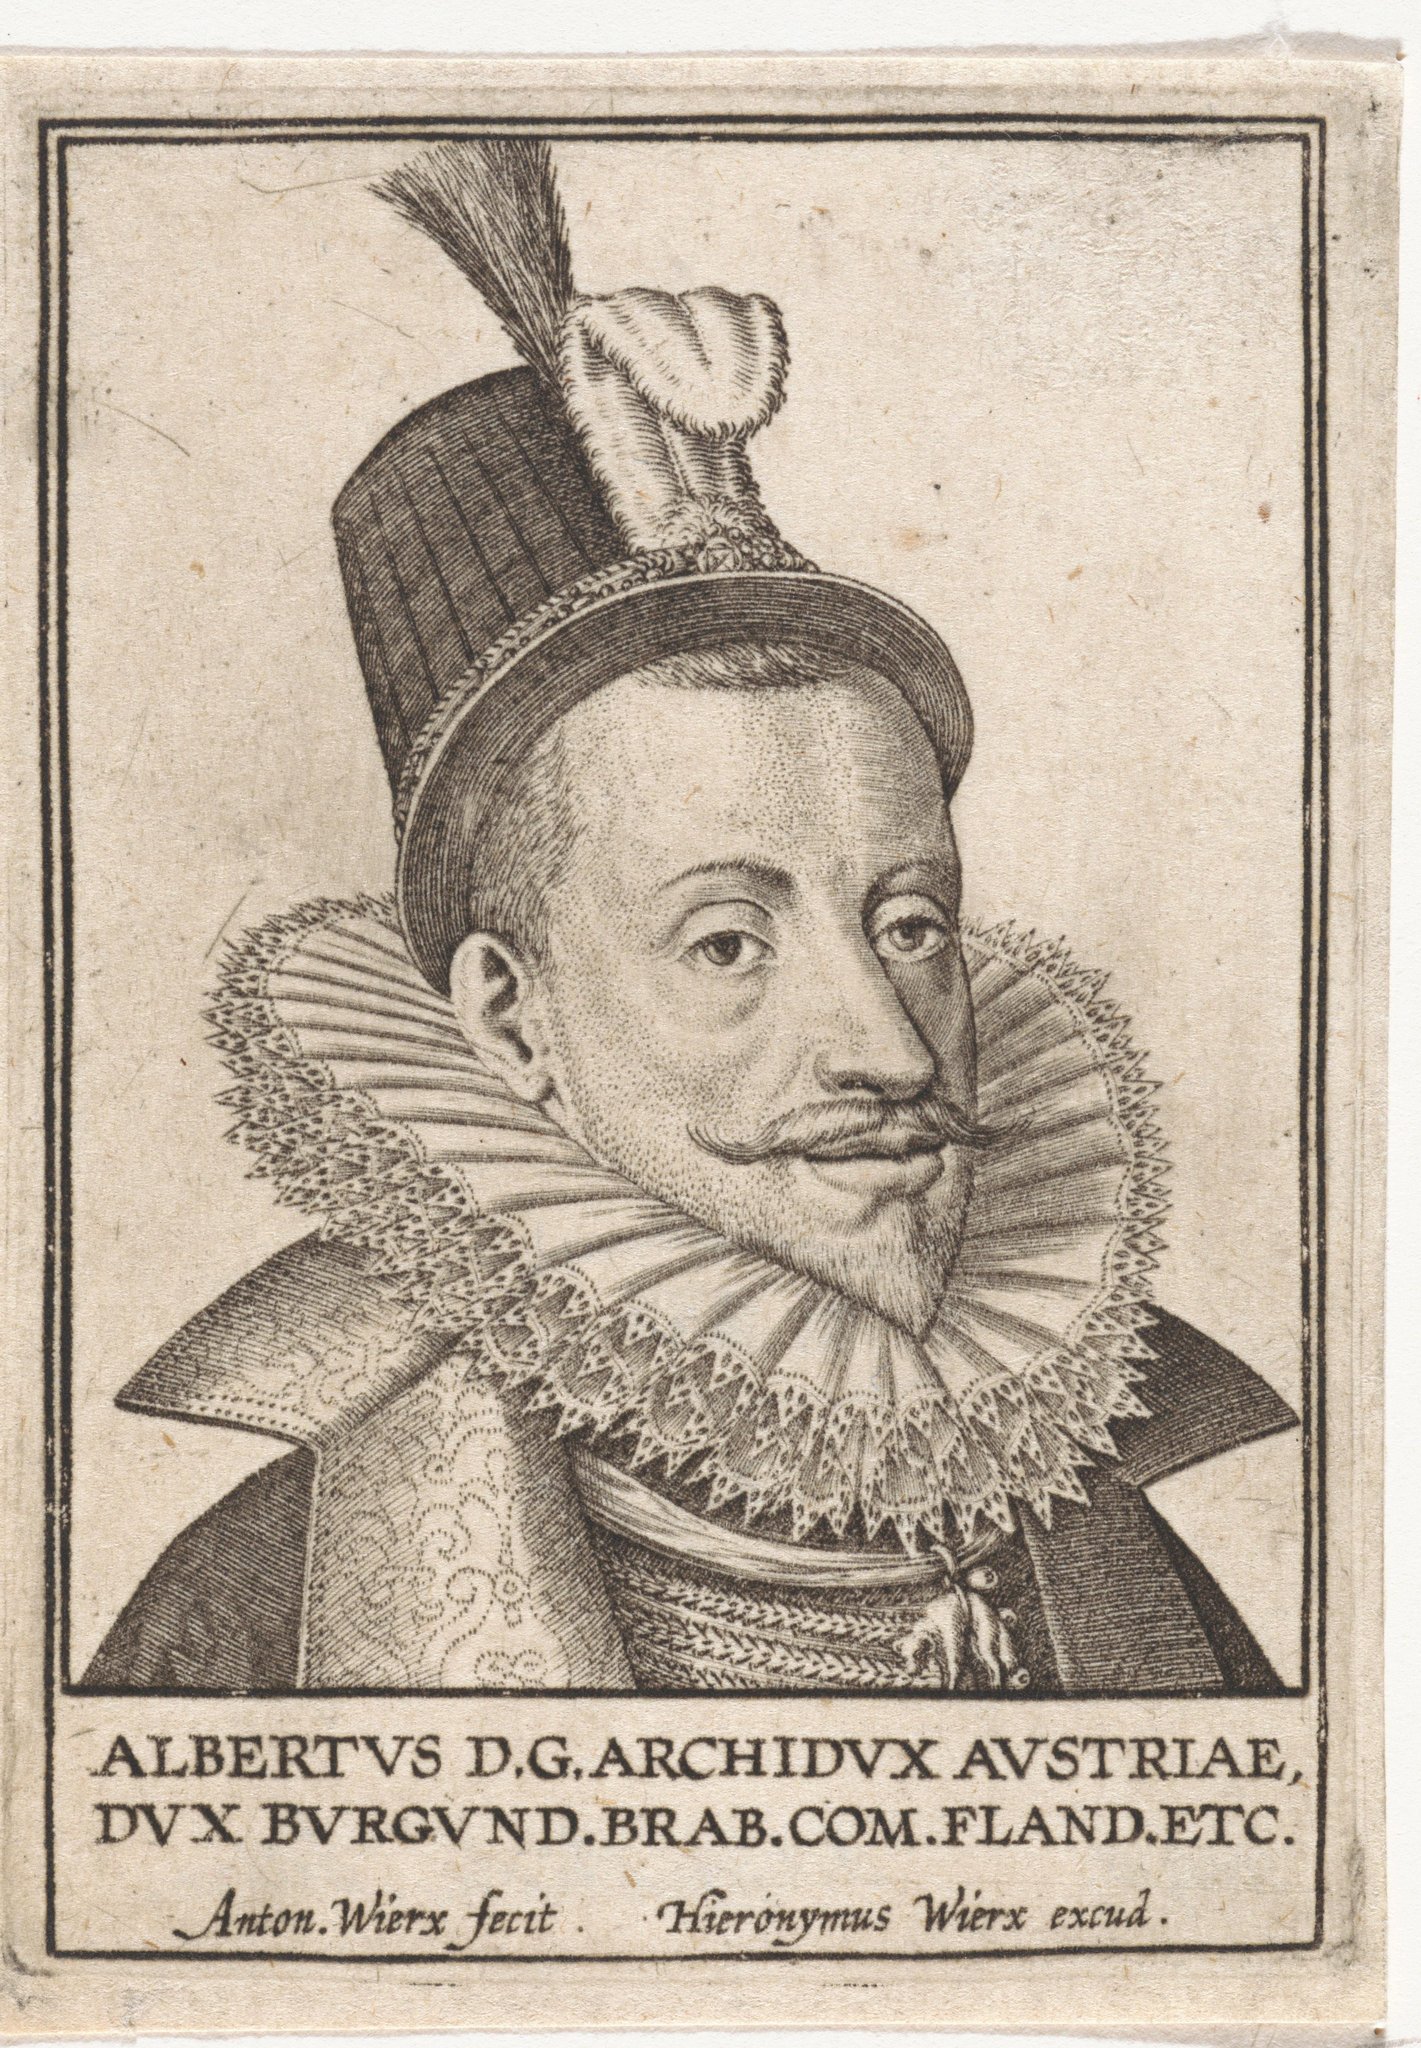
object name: print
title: Portret van Albrecht, aartshertog van Oostenrijk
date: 1598-1604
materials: paper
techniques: engraving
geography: antwerp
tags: albrecht aartshertog van oostenrijk, knighthood order of the golden fleece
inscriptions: collector's mark: Lugt 2228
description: Portret van Albrecht, aartshertog van Oostenrijk. Hij draagt een lint met de Orde van het Gulden Vlies. In de marge een tweeregelig onderschrift in het Latijn.